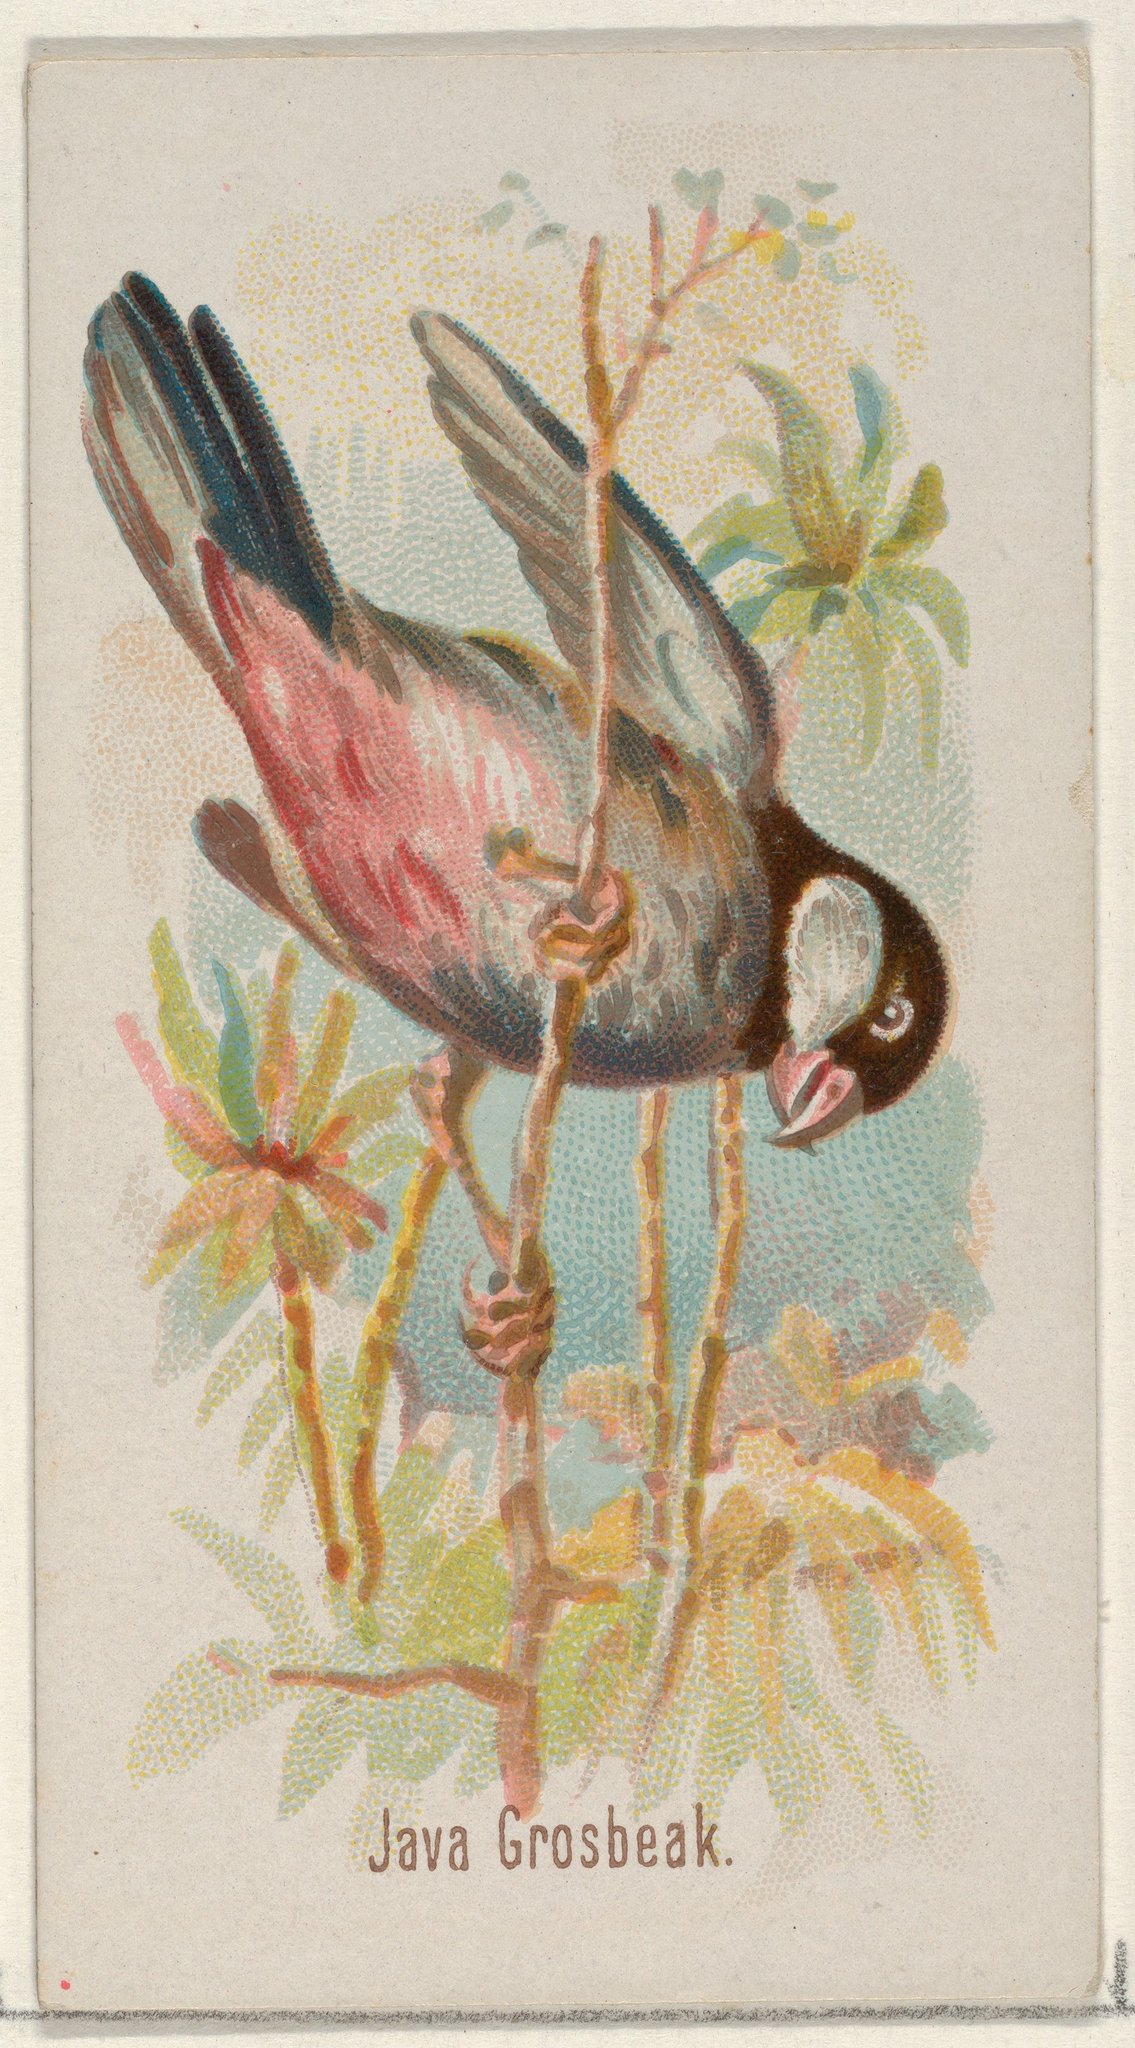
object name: print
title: Java Grosbeak, from the Song Birds of the World series (N23) for Allen & Ginter Cigarettes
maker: allen & ginter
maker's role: publisher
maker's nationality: american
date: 1890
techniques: color lithograph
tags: birds